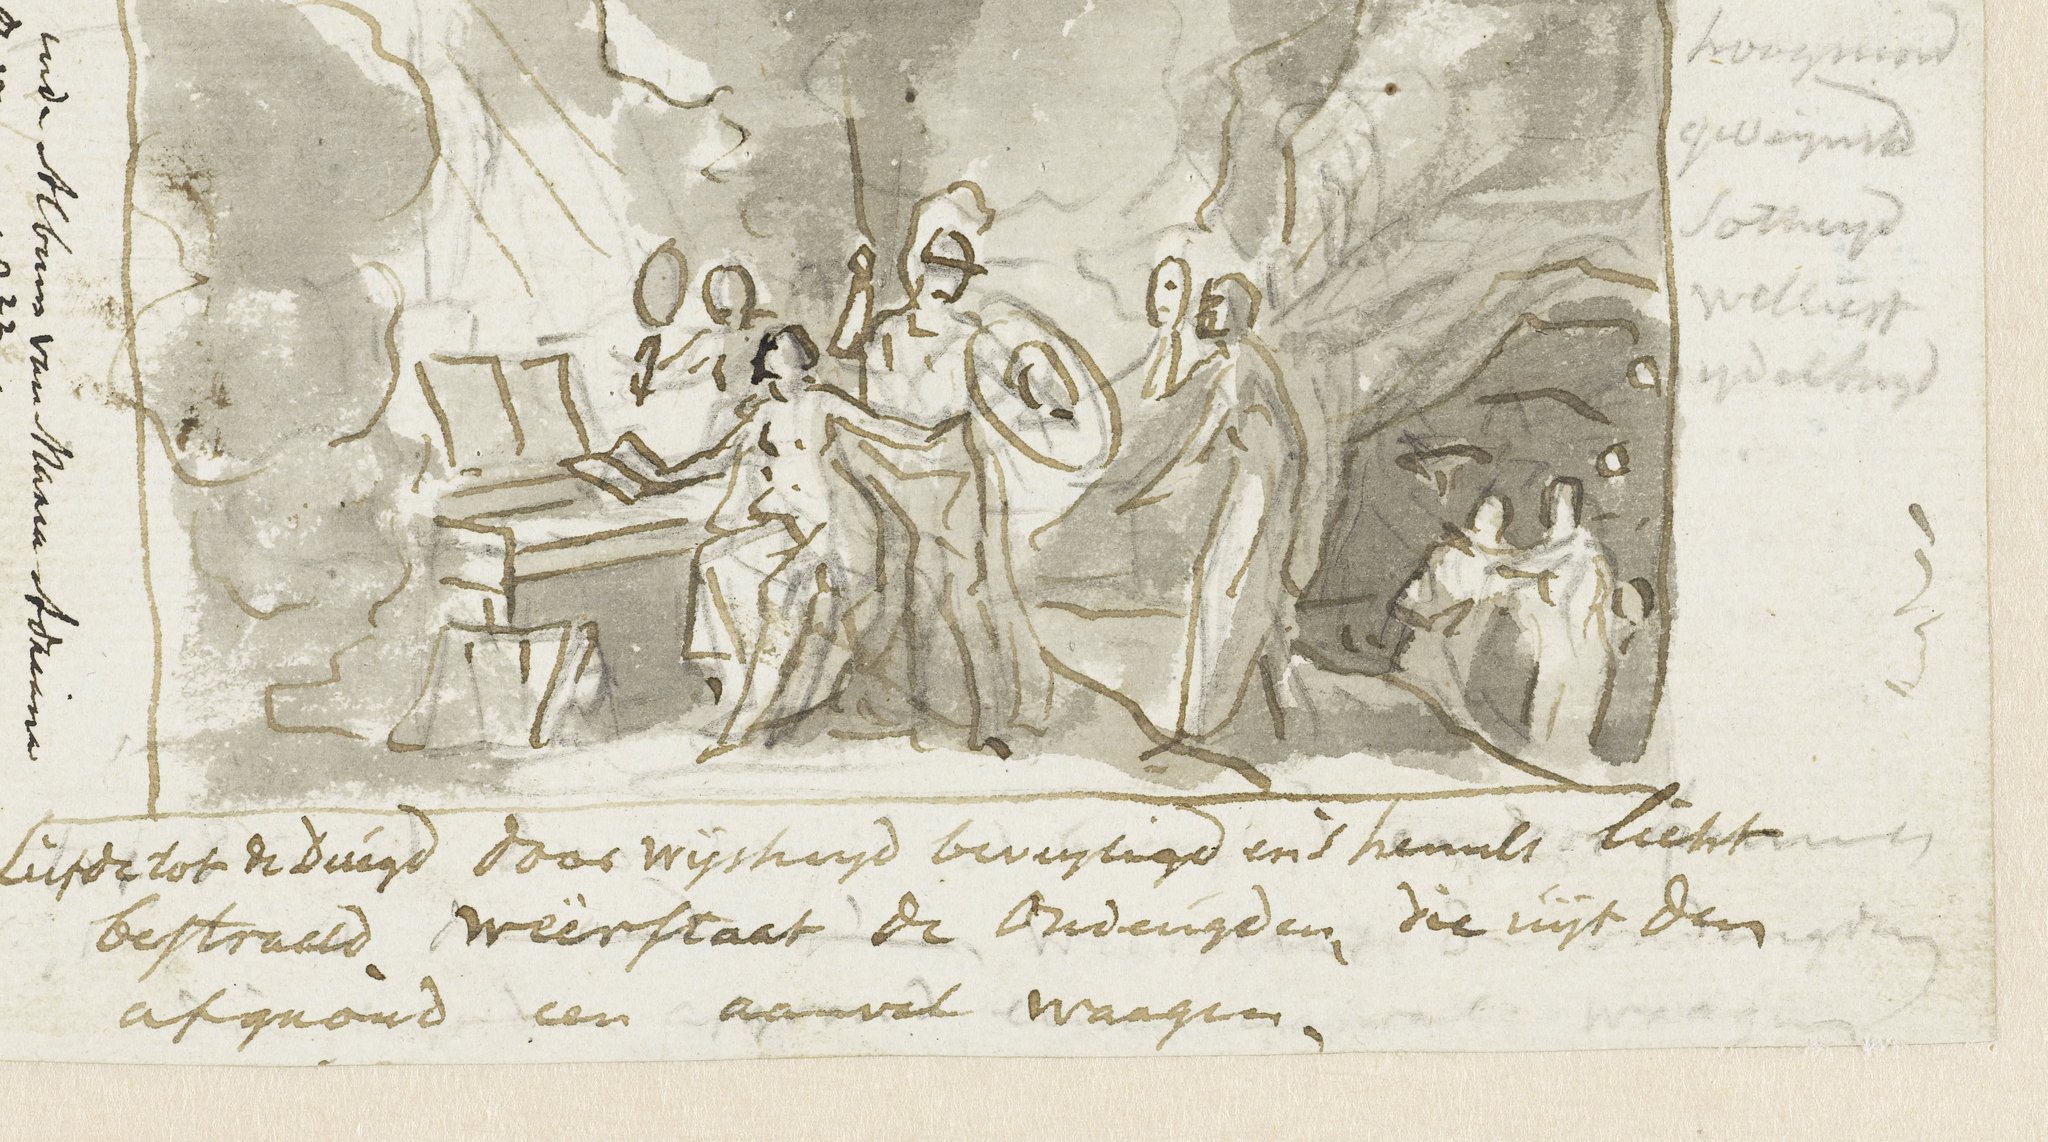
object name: drawing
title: Liefde tot de Deugd door Wijsheid bevestigd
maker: jurriaan andriessen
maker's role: draughtsman, painter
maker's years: 1742-1819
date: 1804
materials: graphite, ink, paper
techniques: brush, pen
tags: strife between virtues and vices, psychomachy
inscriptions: : ‘Liefde tot de Deugd door Wijsheyd bevestigd in 't hemels licht bestraeld, weerstaat de Ondeugden die uyt den afgrond een aanval waagen’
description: Schets van een zinnebeeldige voorstelling.